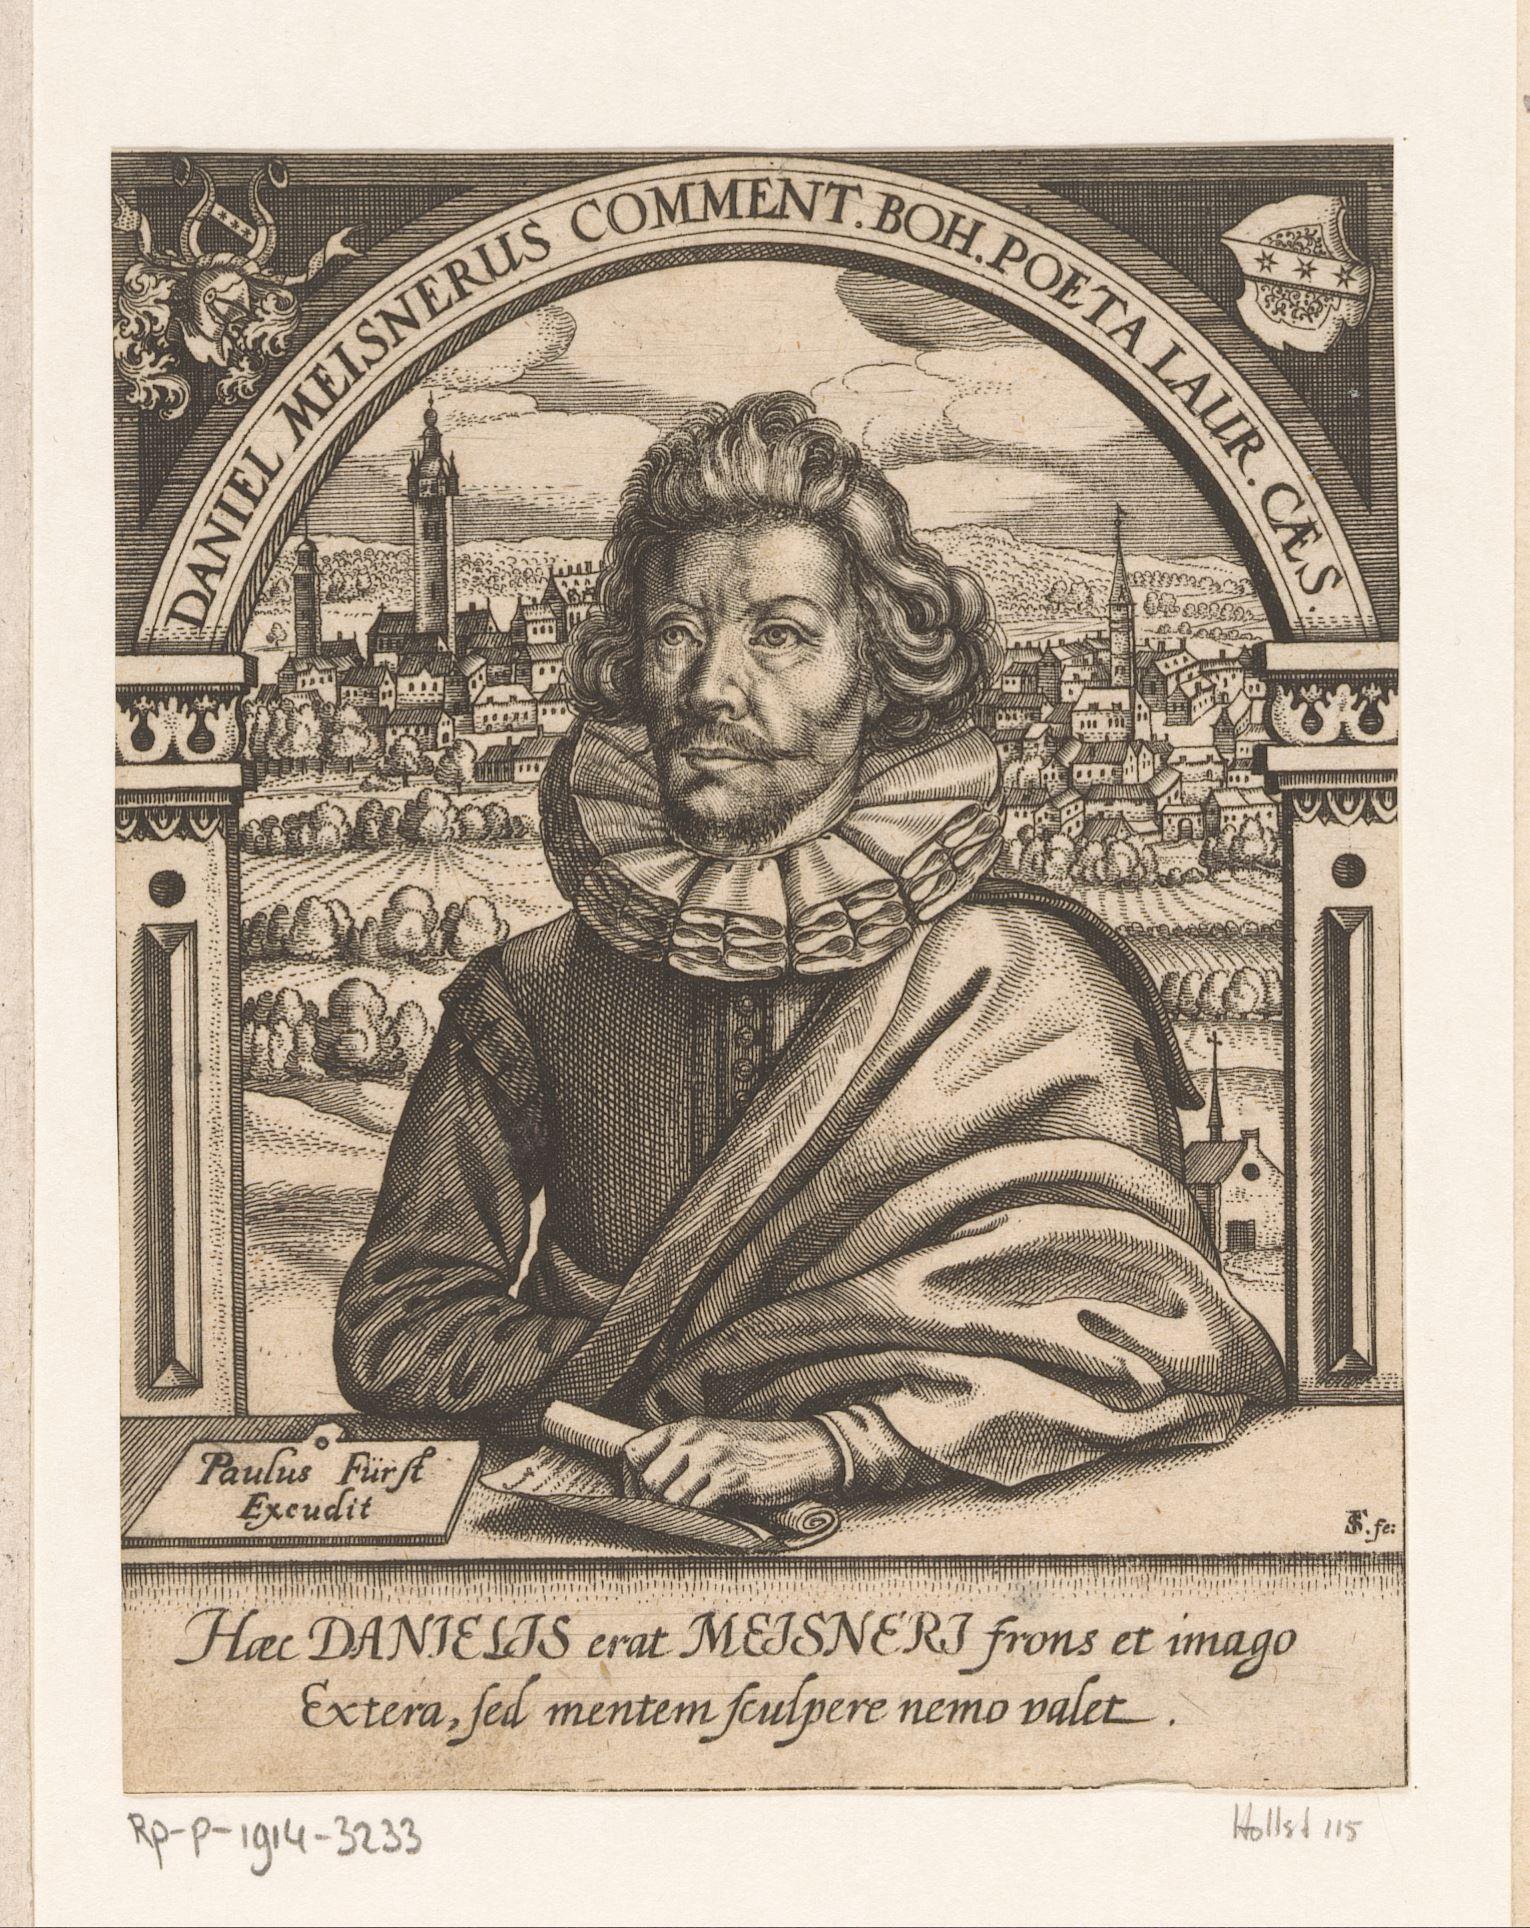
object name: print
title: Portret van Daniel Meisner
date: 1625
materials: paper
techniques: engraving, etching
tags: daniel meisner (1585-1625), city-view, and landscape with man-made constructions, historical persons, armorial bearing, heraldry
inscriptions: collector's mark: Lugt 2228